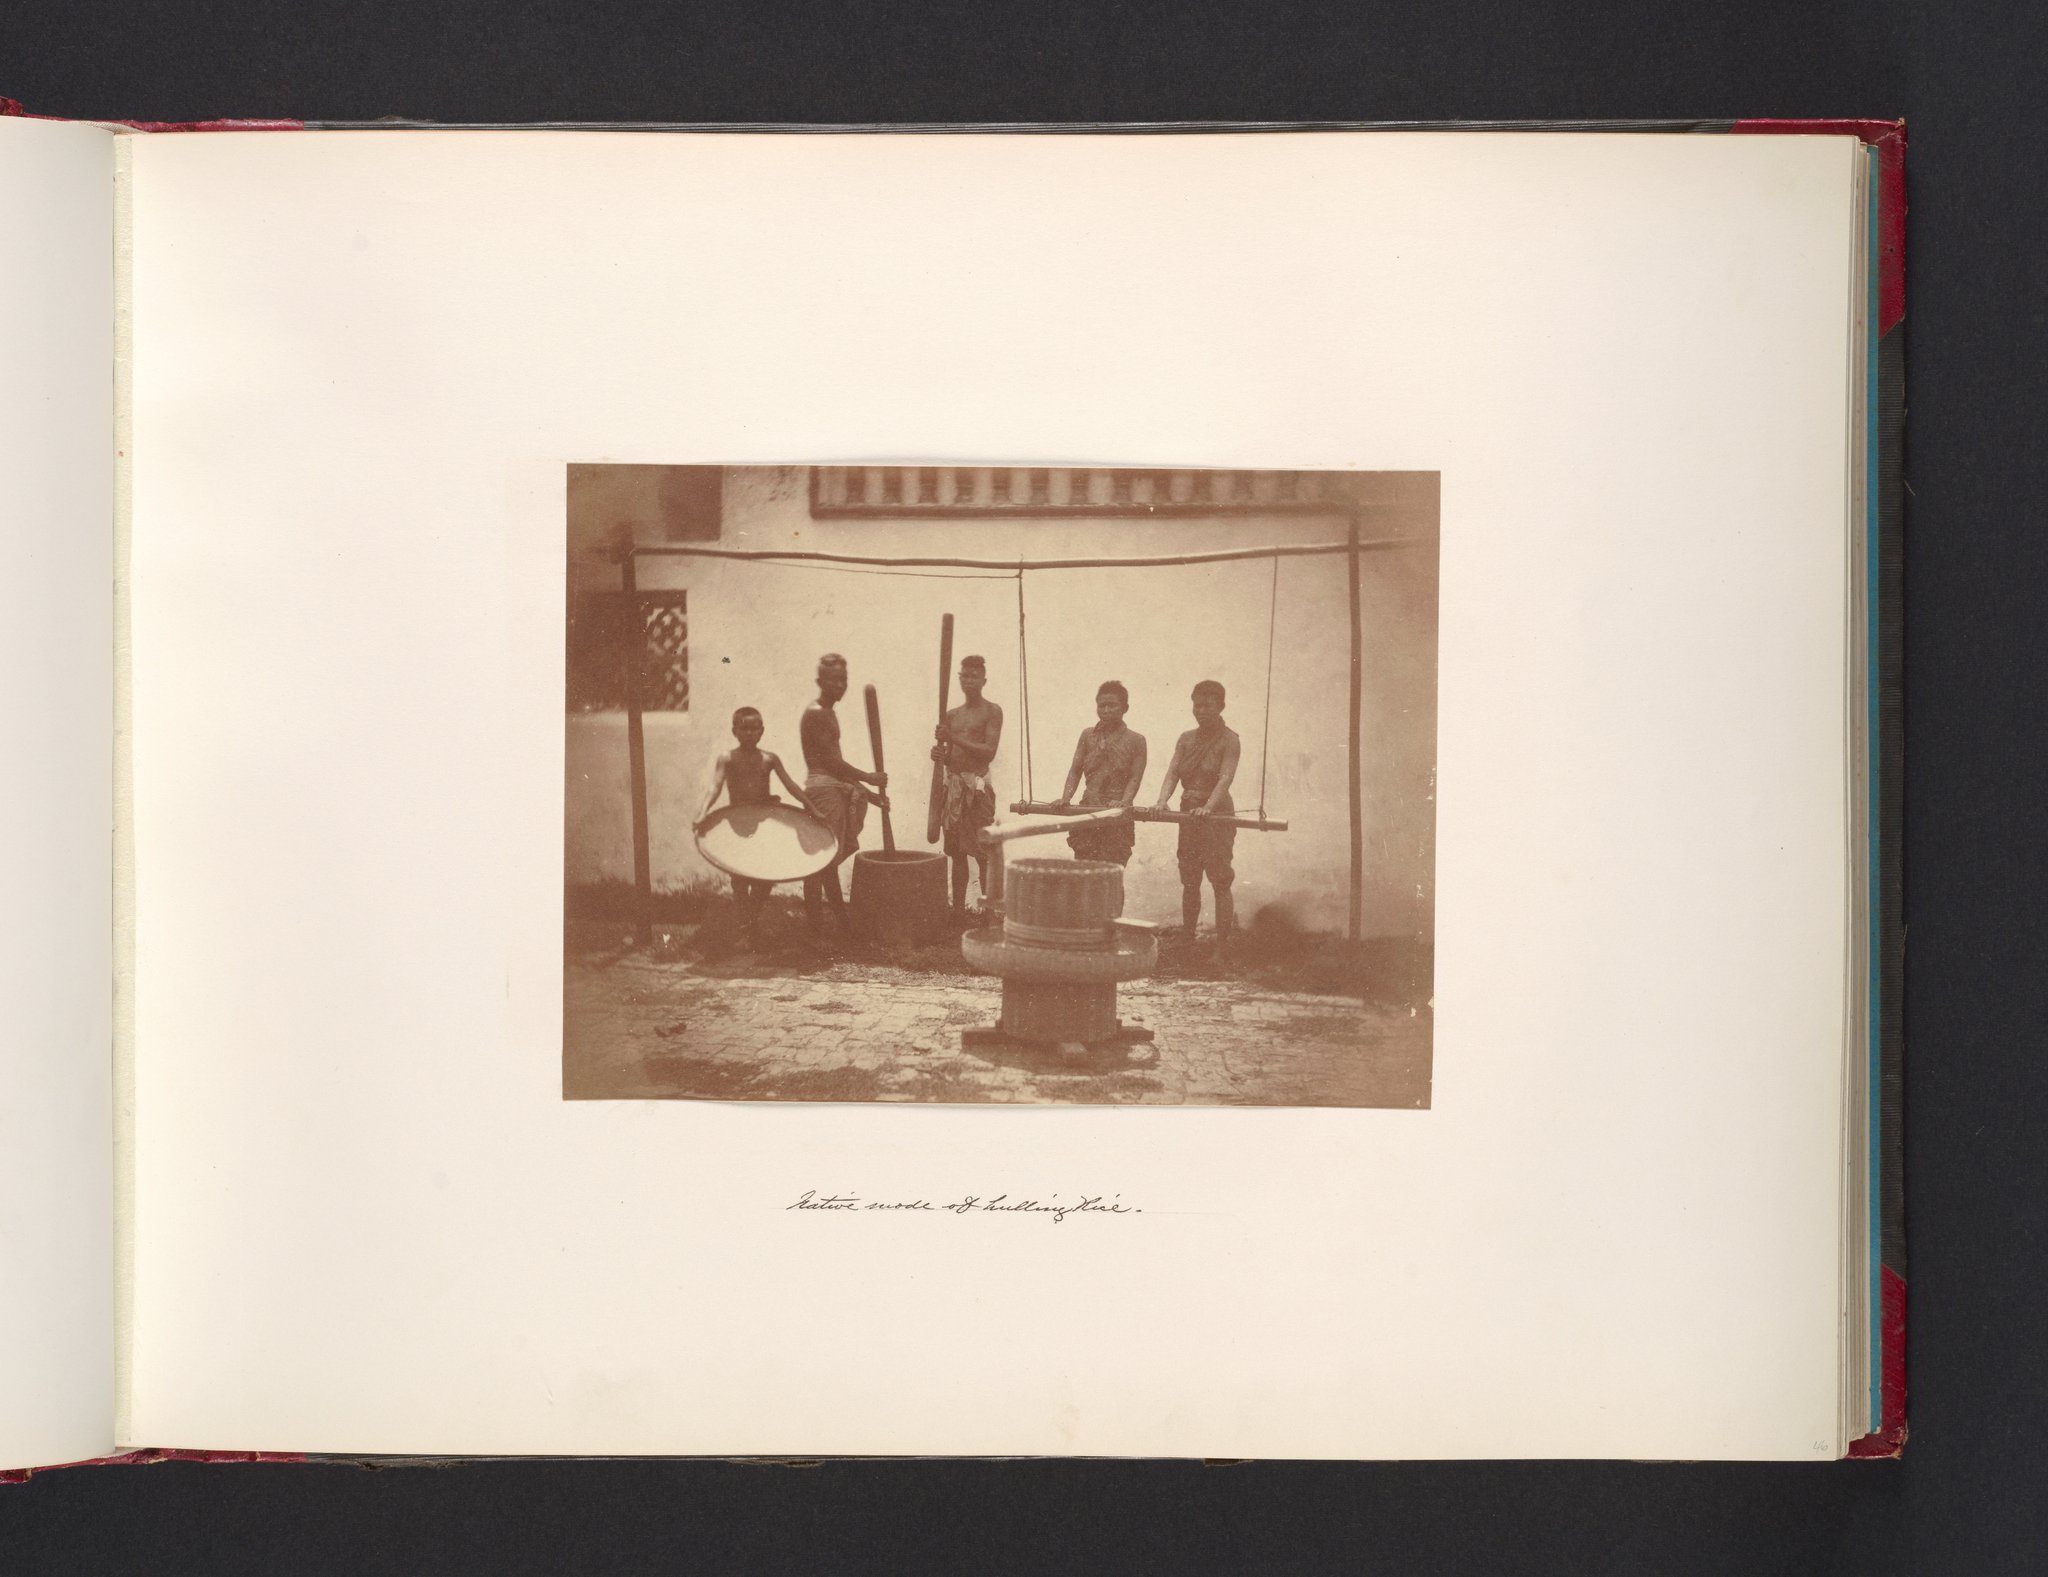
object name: photograph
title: Native Mode of Hulling Rice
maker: john thomson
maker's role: artist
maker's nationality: british, scottish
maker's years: 1837-1921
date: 1865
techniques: albumen silver print, glass negative